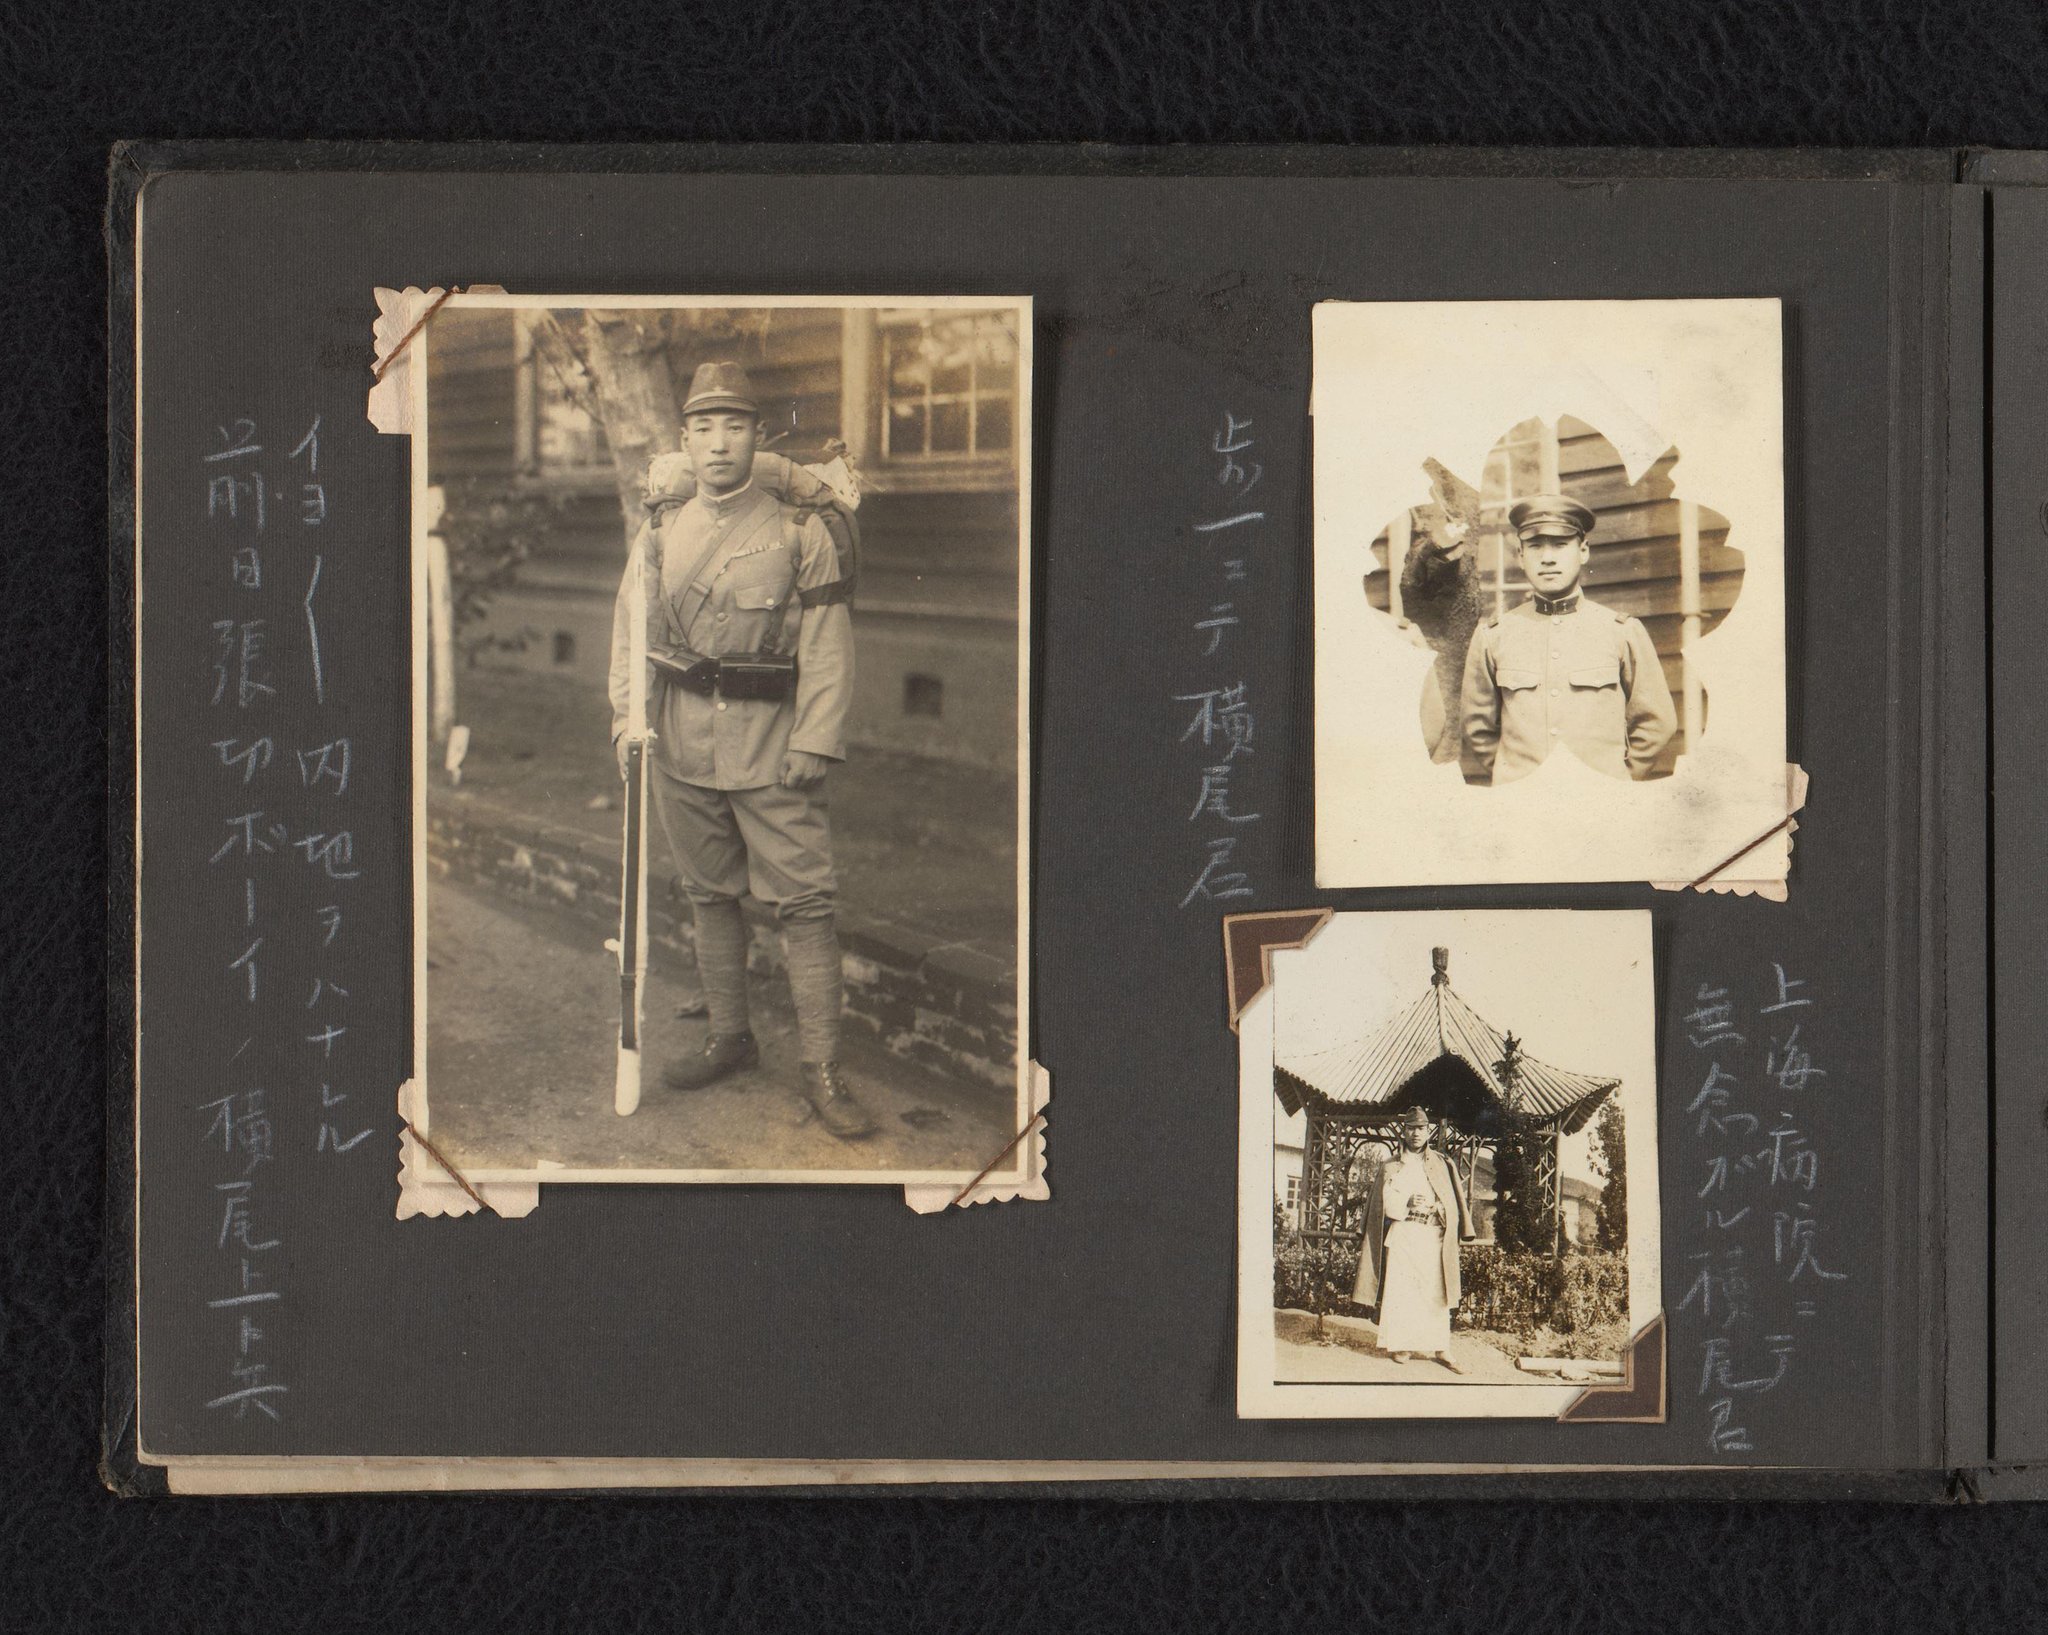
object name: album leaf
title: Drie portretten van onbekende Japanse soldaten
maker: Anonymous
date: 1937-1941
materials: paper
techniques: gelatin silver print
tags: anonymous historical person portrayed, the soldier; the soldier's life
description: Deze foto's zijn onderdeel van een album.